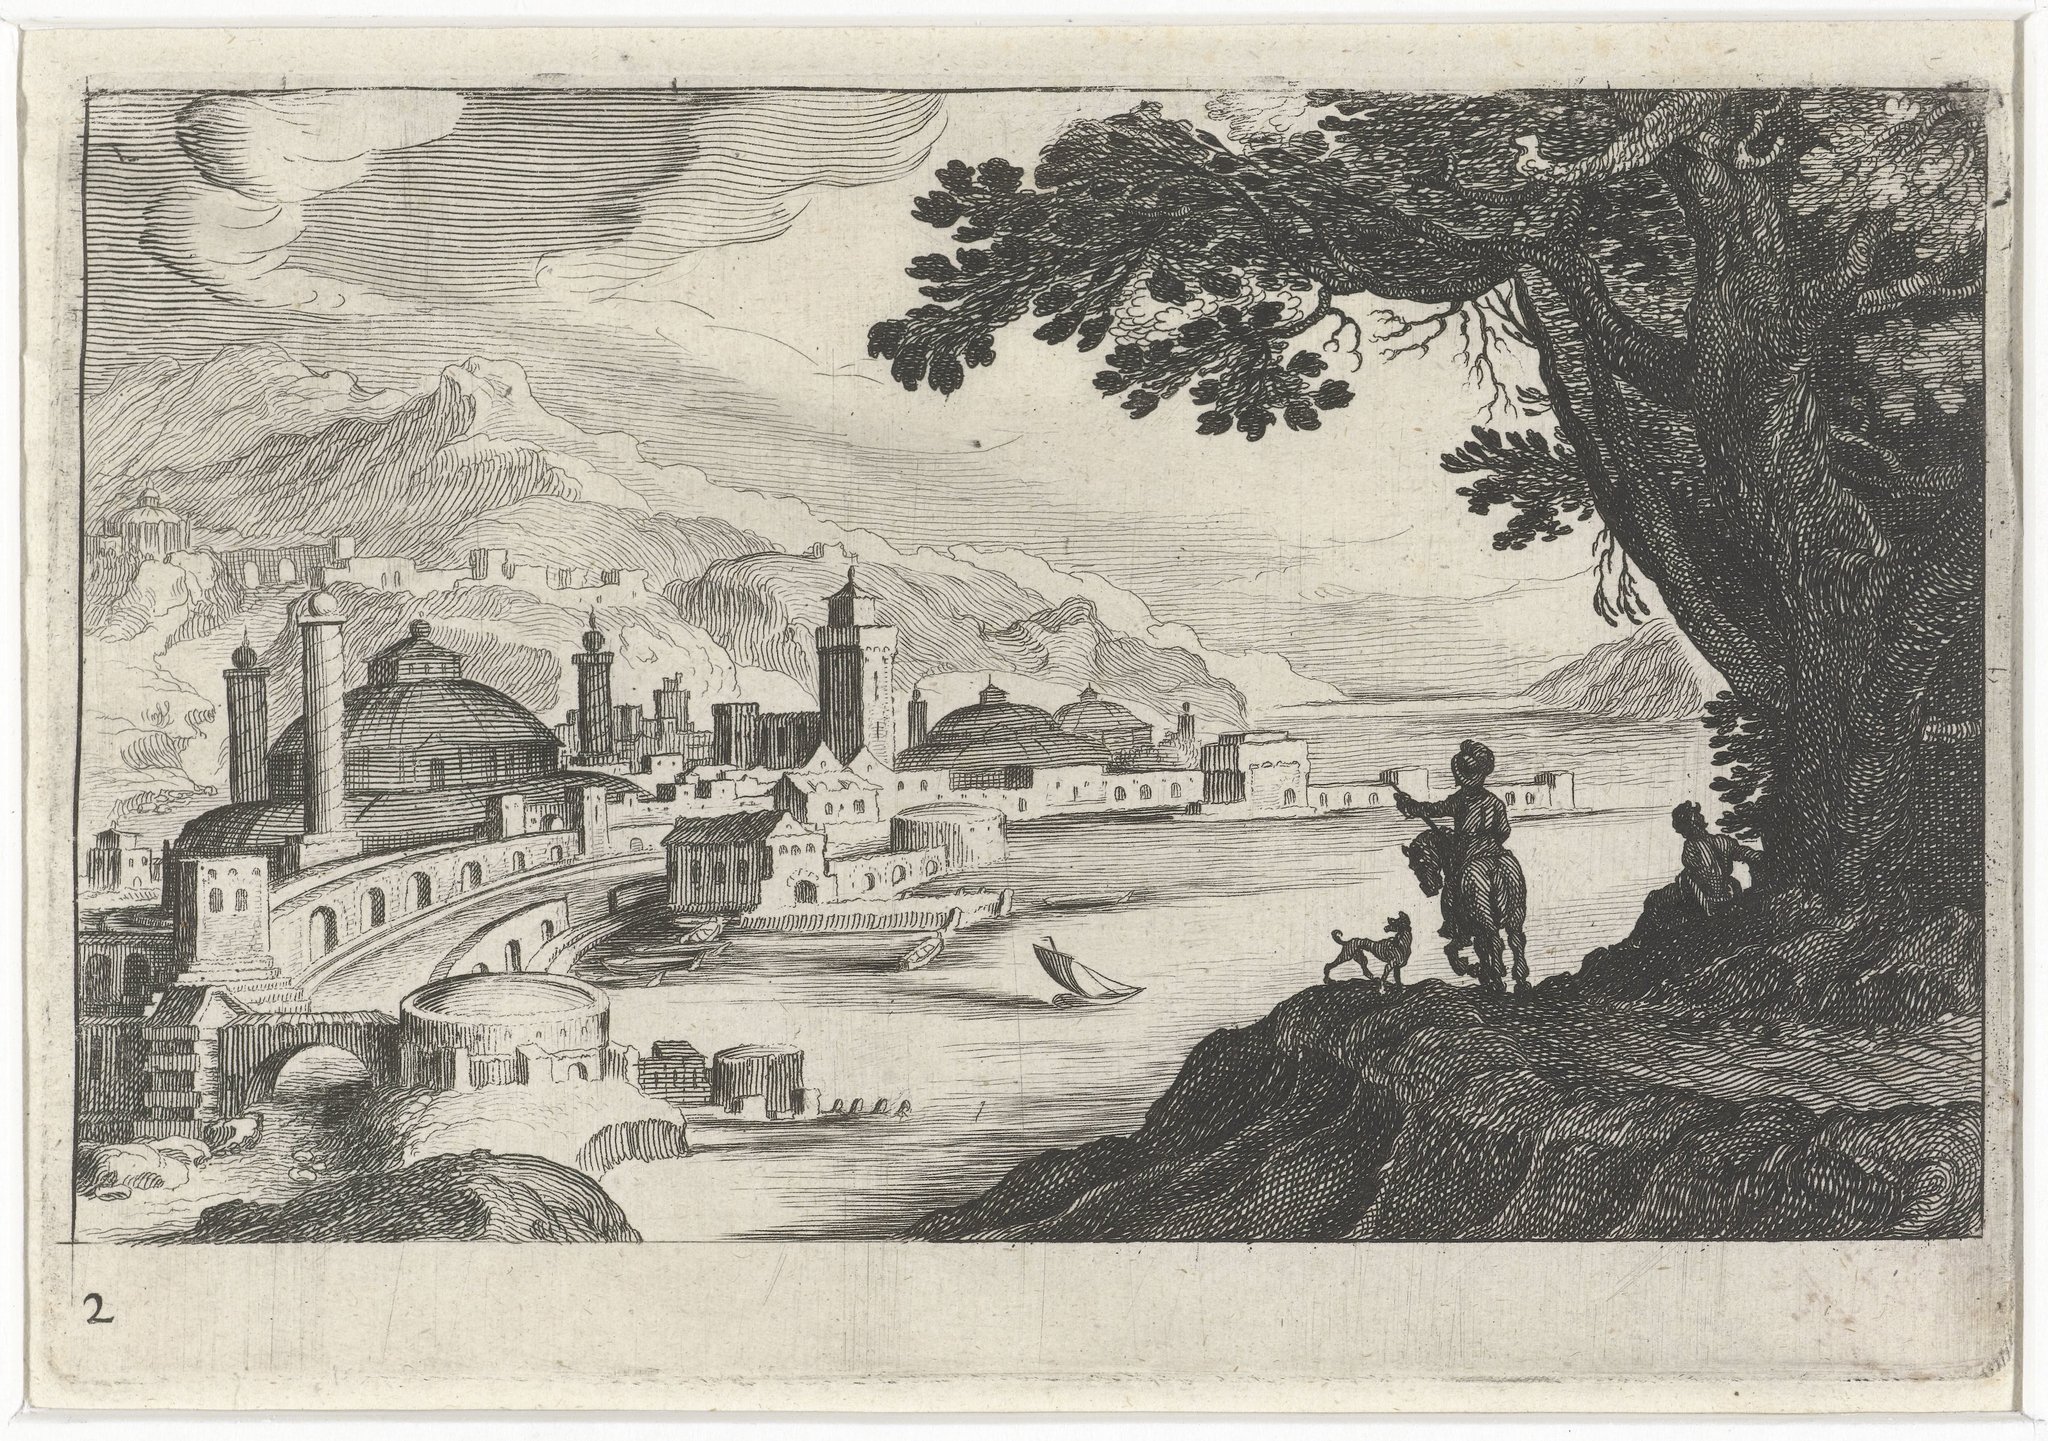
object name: print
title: Topographia variarum regionum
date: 1611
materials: paper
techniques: etching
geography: the hague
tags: prospect of city, town panorama, silhouette of city (+ city(-scape) with figures, staffage)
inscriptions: collector's mark: Lugt 240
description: Stadsgezicht met een gebouw met een koepelvormig dak, rechts op de voorgrond een man te paard vergezeld door een hond onder een boom.